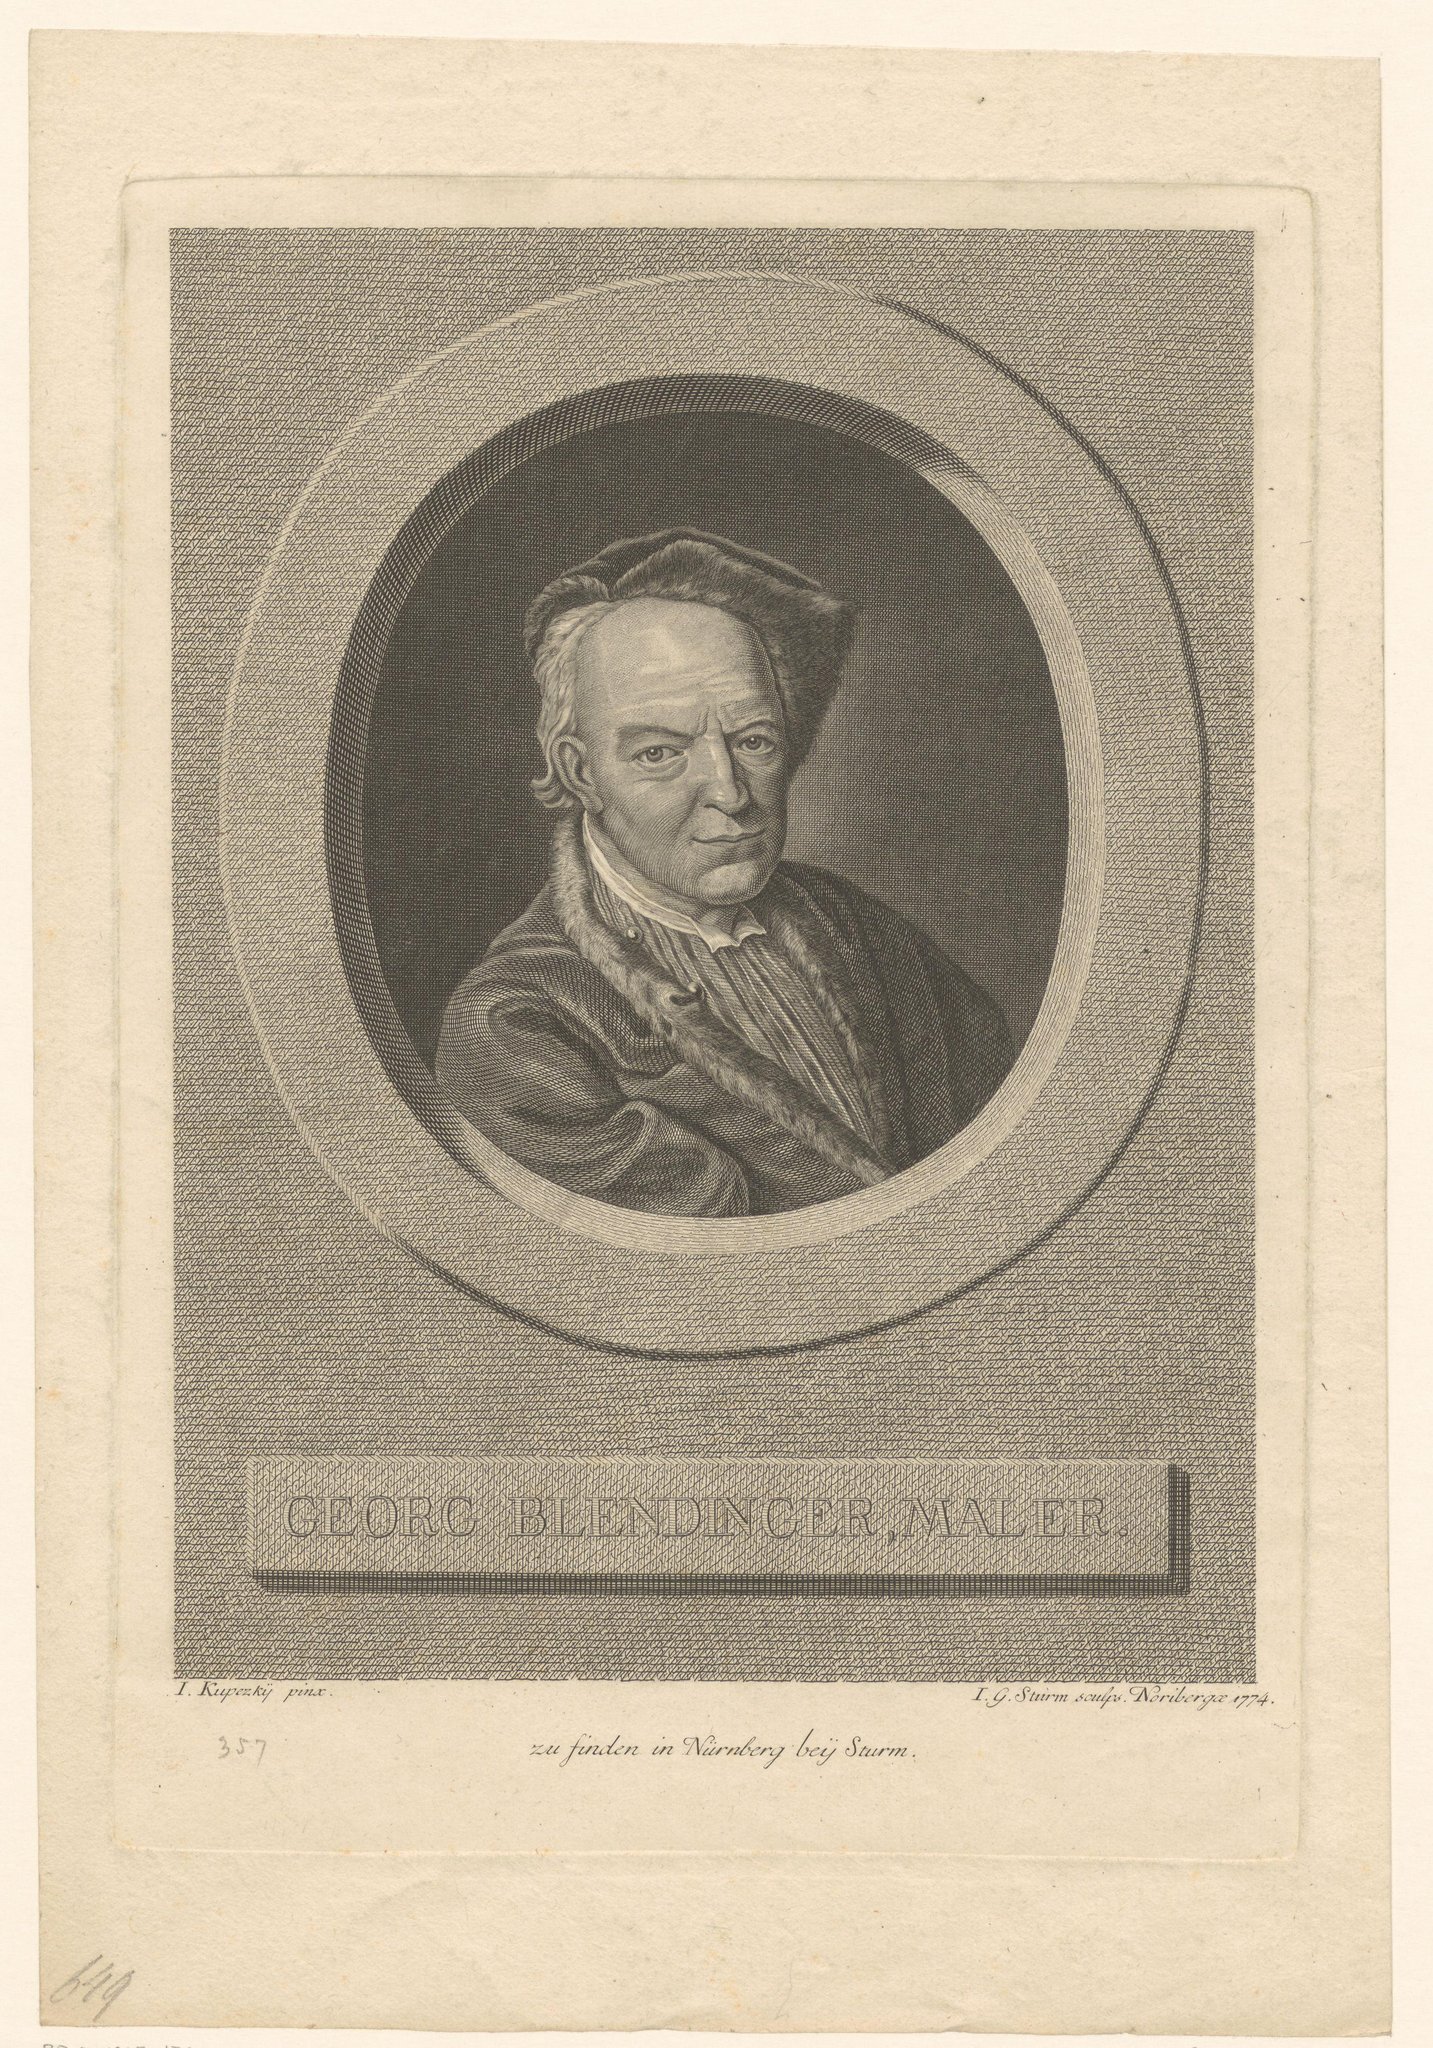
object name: print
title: Portret van Georg Blendinger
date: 1774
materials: paper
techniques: engraving, etching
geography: nuremberg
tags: painter, georg blendinger, historical persons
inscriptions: collector's mark: Lugt 2228